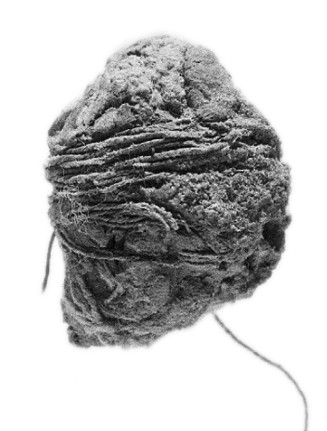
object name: sealing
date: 1981-1640 BCE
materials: mud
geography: egypt